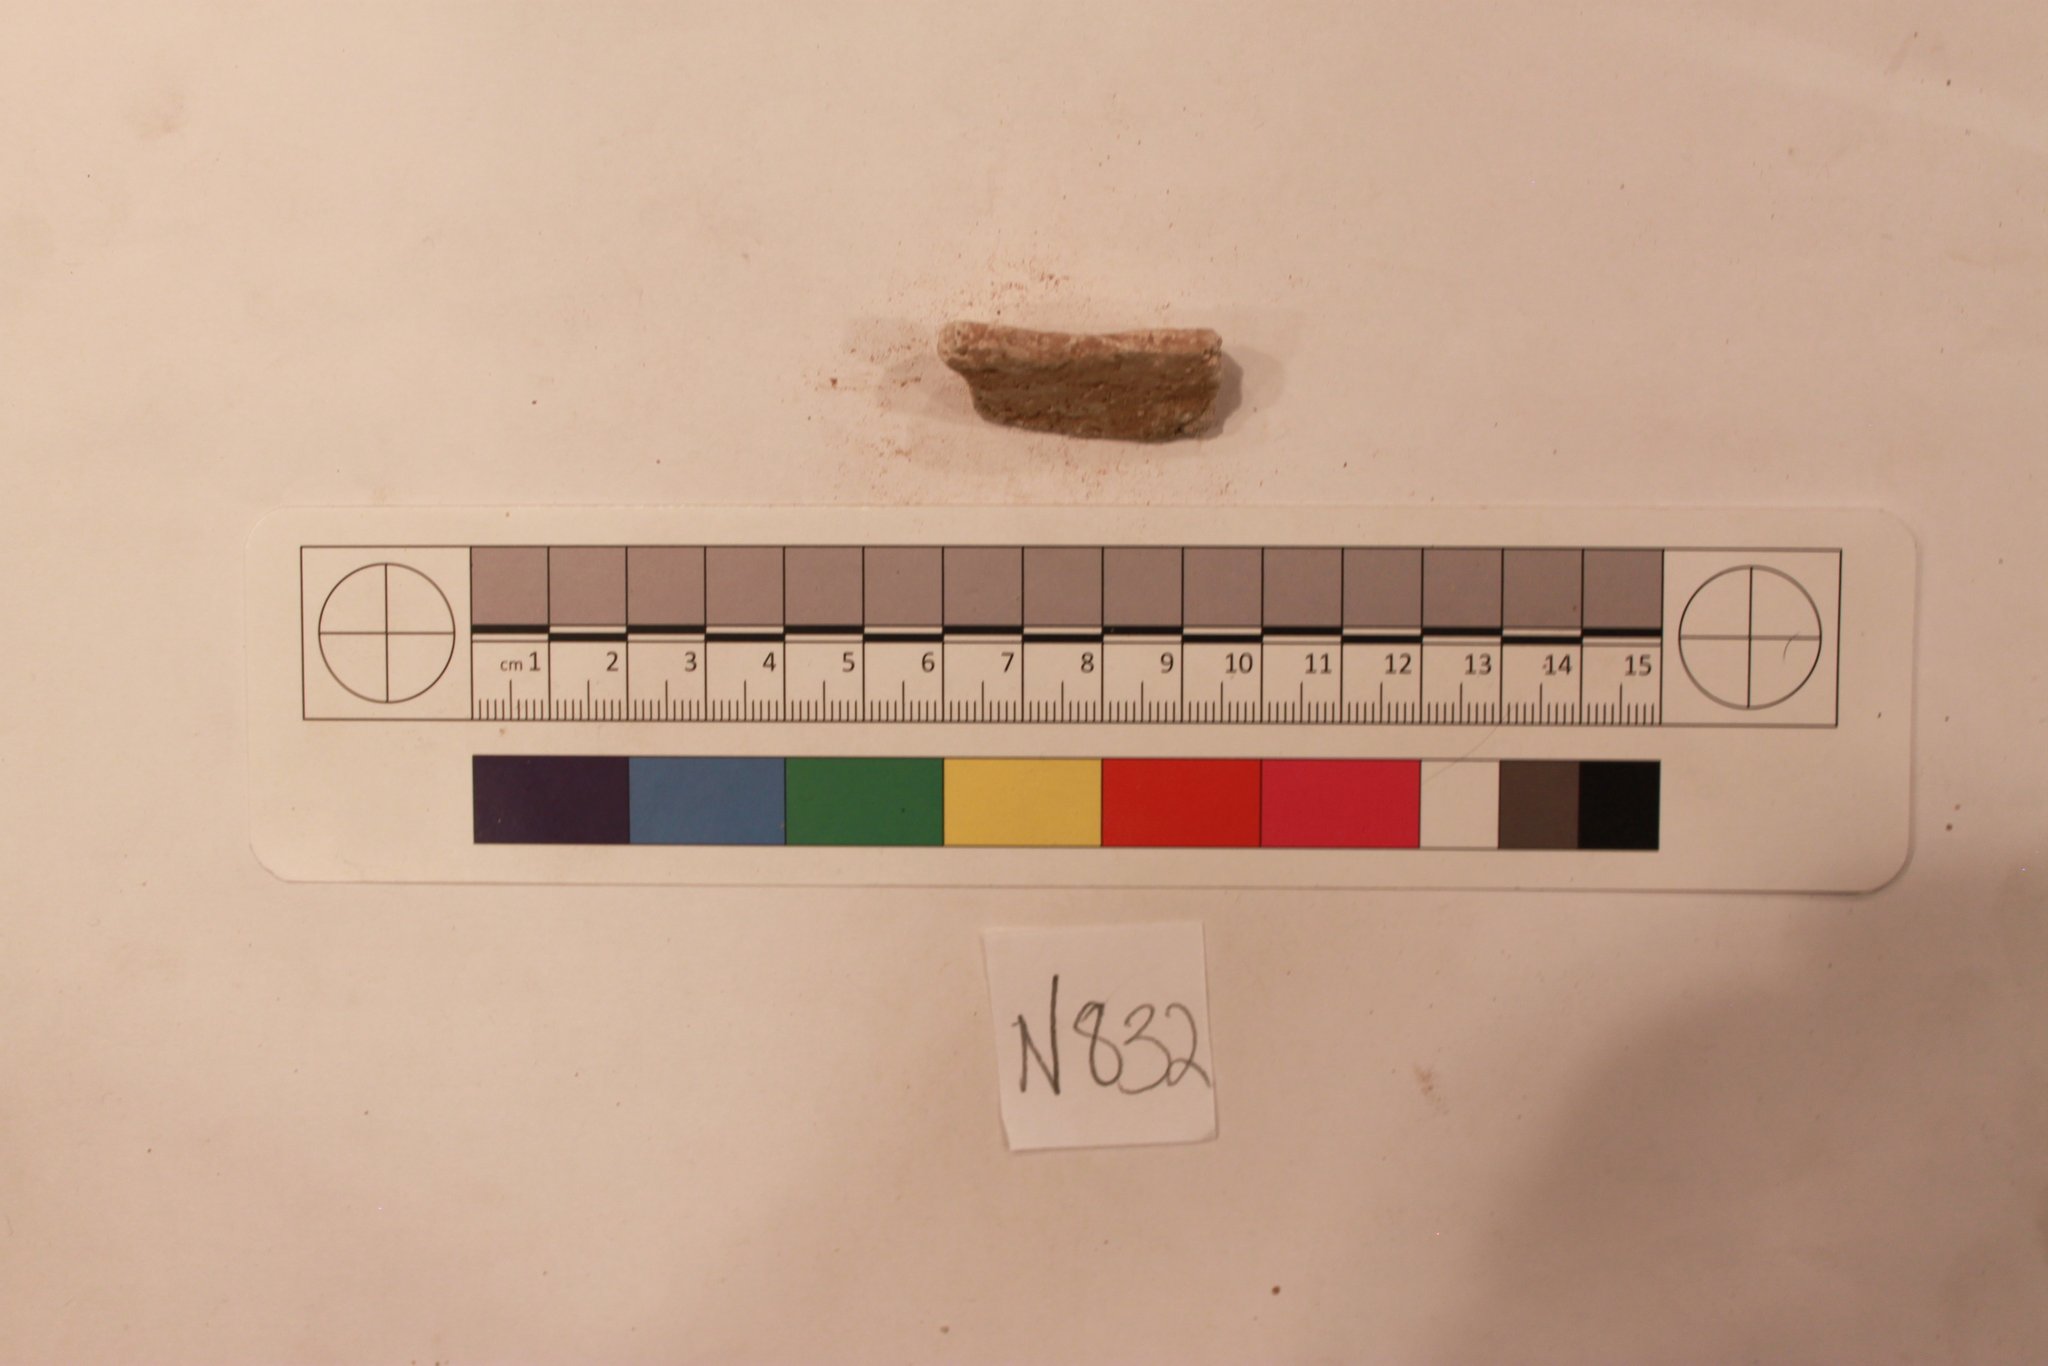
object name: fragment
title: Stucco Fragment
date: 701-1200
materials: plaster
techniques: carving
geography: iran